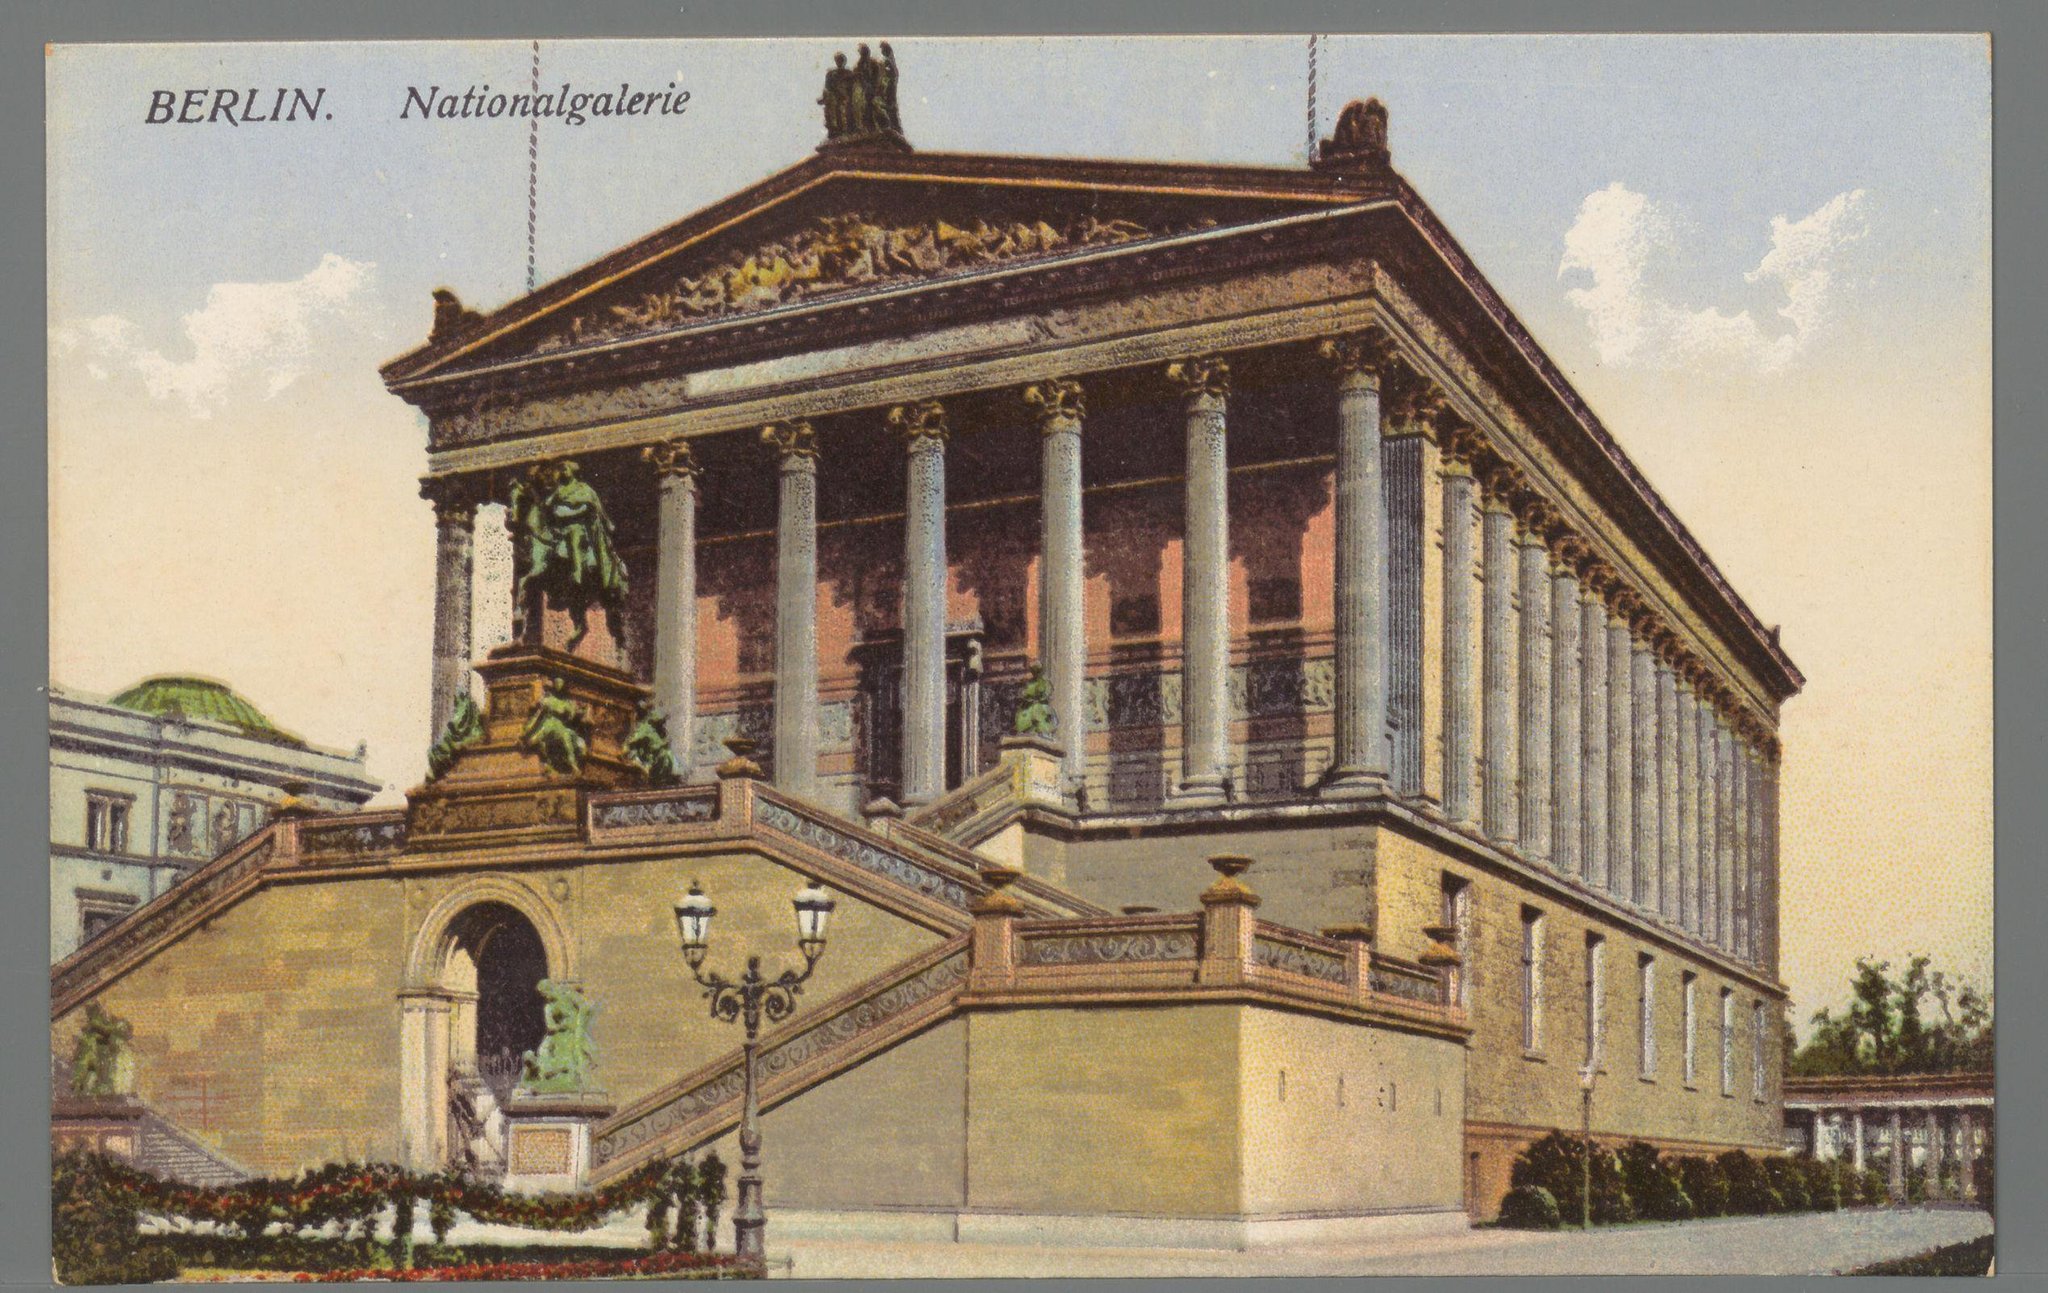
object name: photomechanical print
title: Berlin. Nationalgalerie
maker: Anonymous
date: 1905-1930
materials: cardboard, photographic process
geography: berlin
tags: berlin, frederik willem iv (koning van pruisen), monument, statue, permanent exhibition, museum